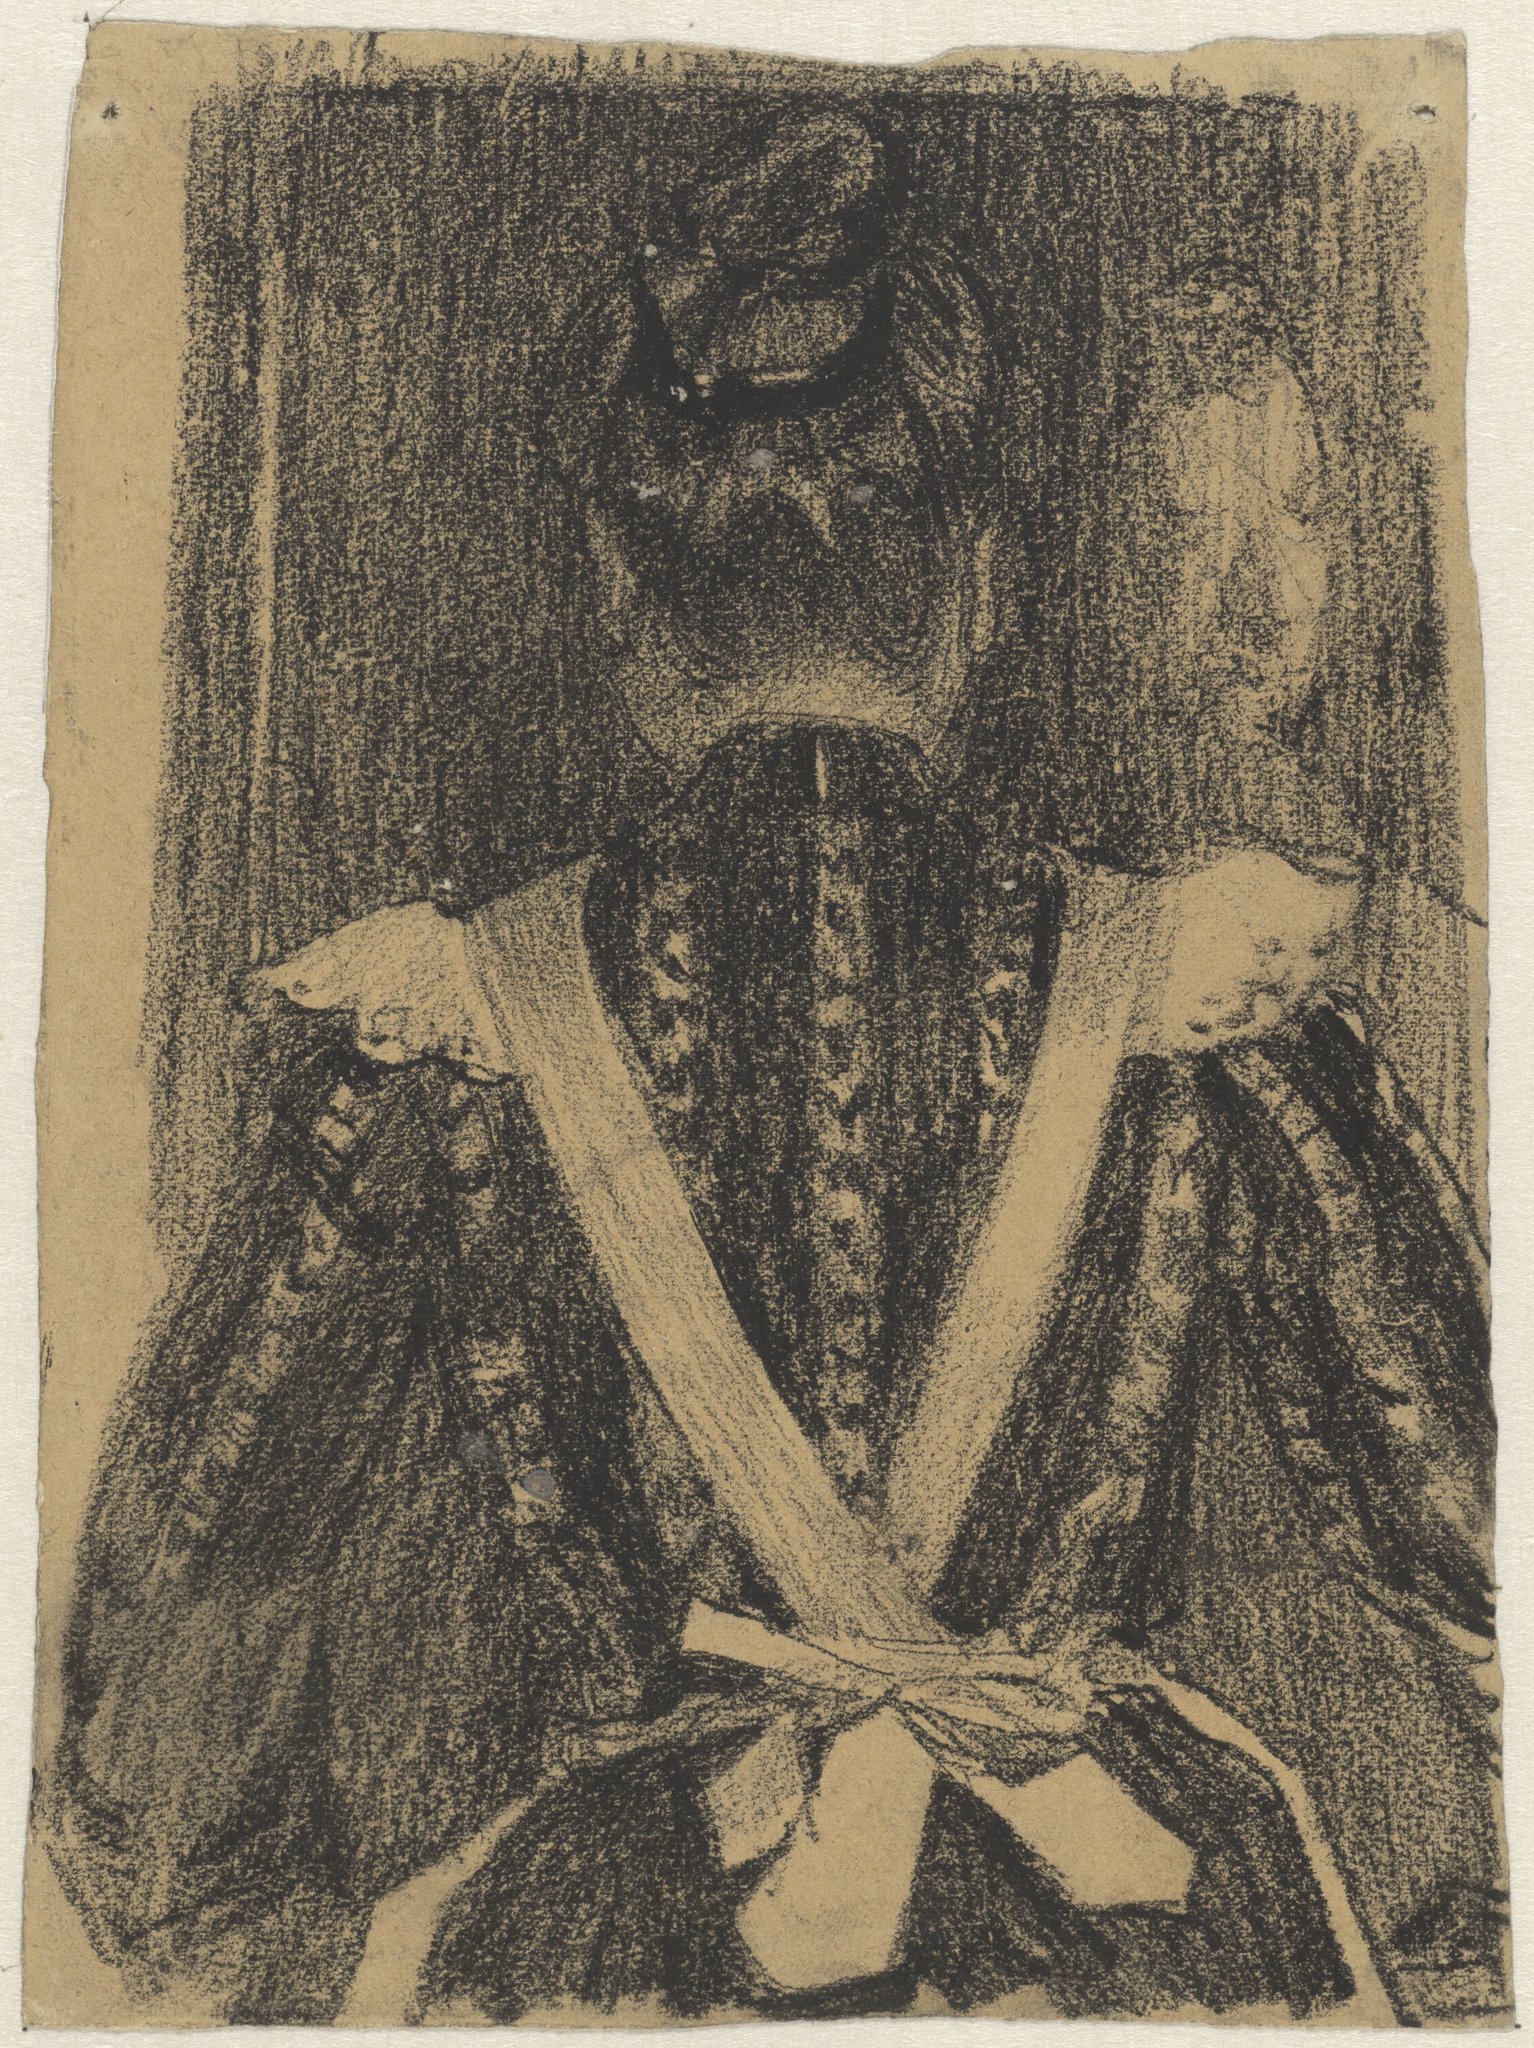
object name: drawing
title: Dienstmeisje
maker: martin monnickendam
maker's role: draughtsman, painter, print maker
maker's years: 1874-1943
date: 1884-1931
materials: chalk, paper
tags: maid ~ house personnel